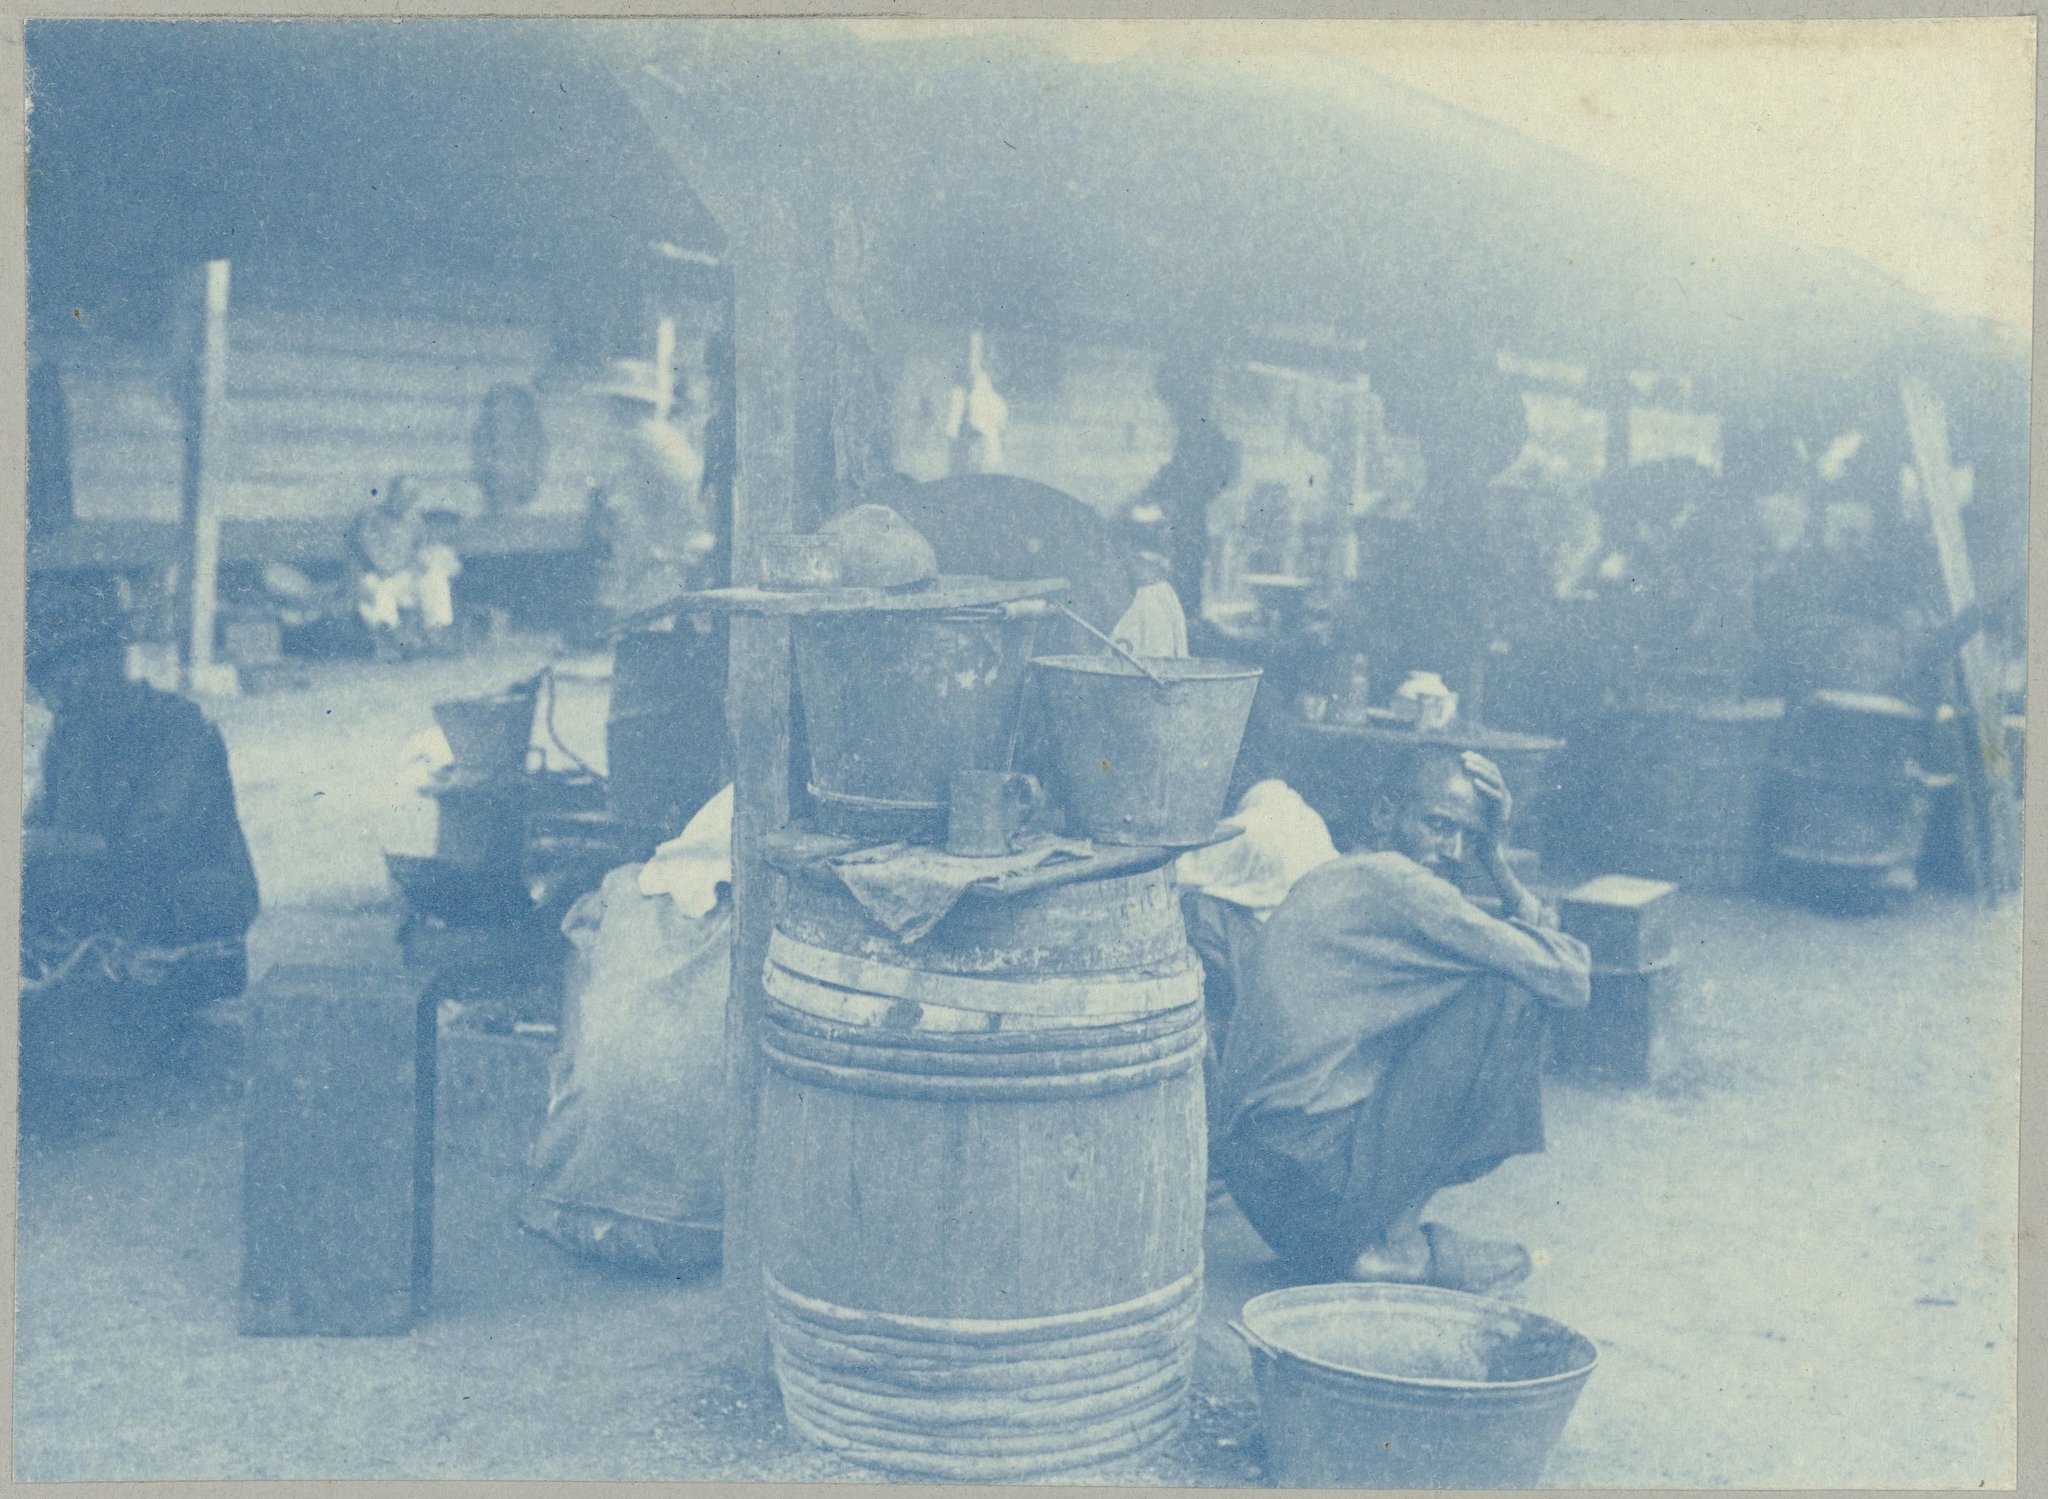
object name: photograph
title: Op 's Landsgrond Boniface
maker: hendrik doijer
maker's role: engineer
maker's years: 1863-1925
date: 1903-1910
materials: photographic support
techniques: cyanotype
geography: suriname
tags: suriname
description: Een man hurkend naast een ton, voor het bejaardenhuis of weldadigheidsgesticht 's-Landsgrond Boniface te Paramaribo. Onderdeel van het fotoalbum Souvenir de Voyage (deel 3), over het leven van de familie Doijer in en rond de plantage Ma Retraite in Suriname in de jaren 1903-1910.